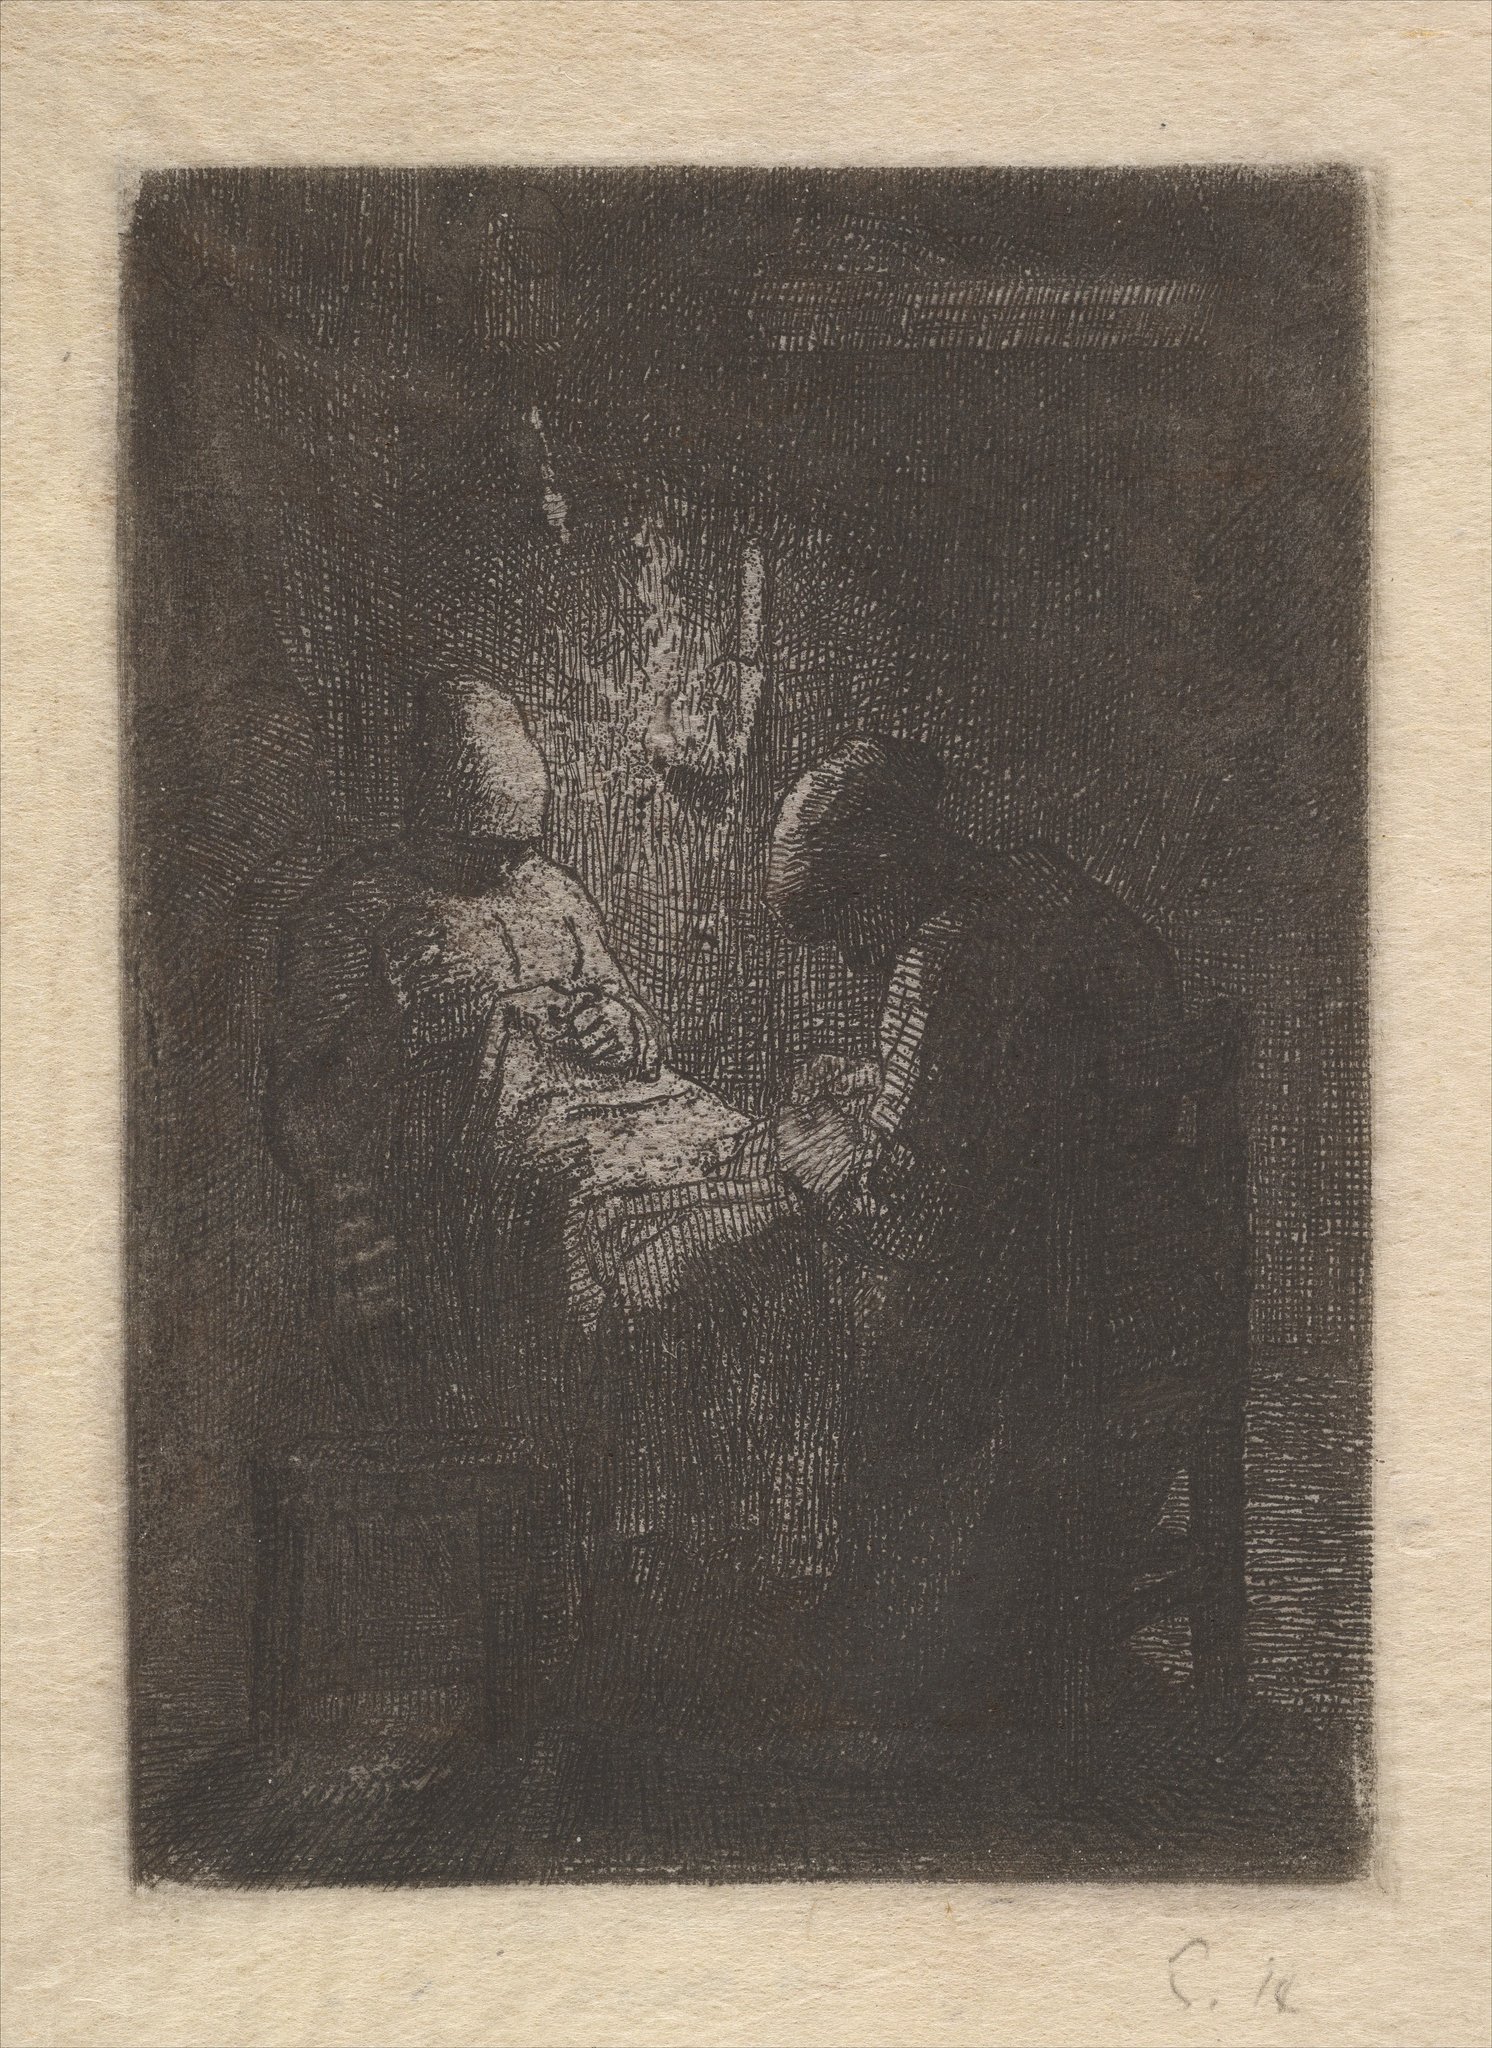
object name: print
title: Two Women Sewing by Lamplight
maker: jean-françois millet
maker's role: artist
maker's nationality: french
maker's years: 1814-1875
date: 1853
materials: zinc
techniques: etching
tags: women,working,sewing